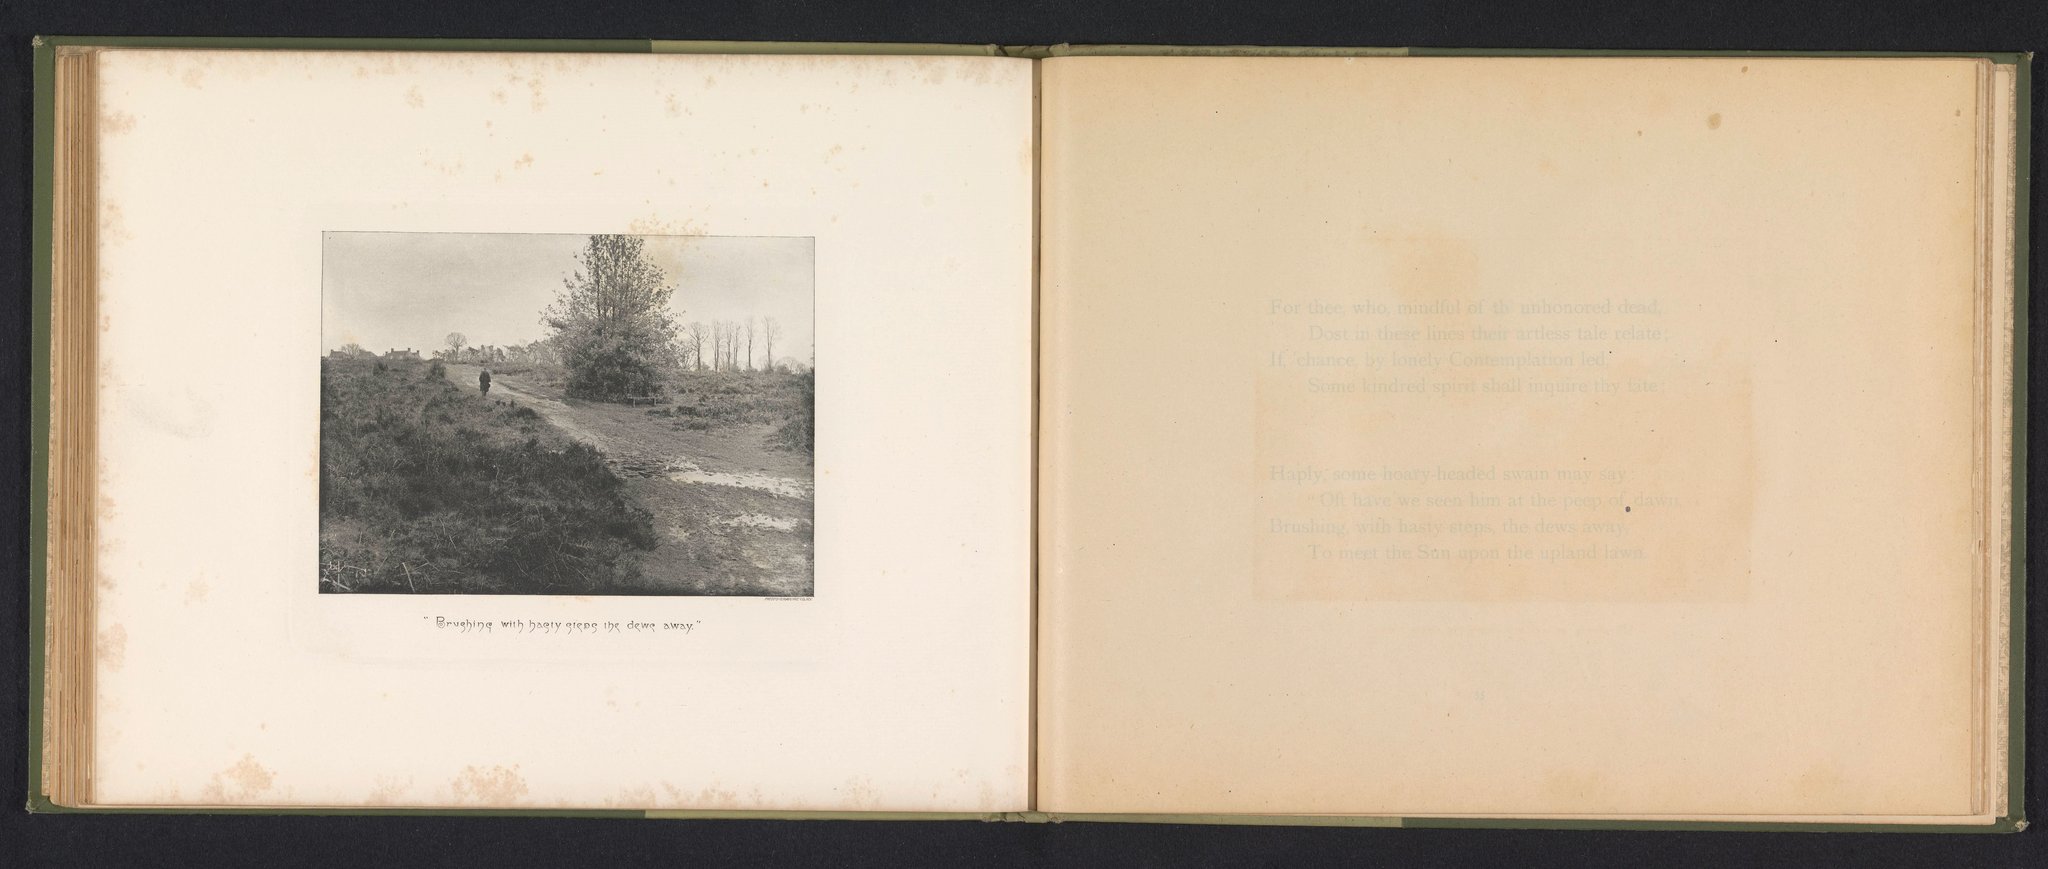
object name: photomechanical print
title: Brushing with hasty steps the dews away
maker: james leon williams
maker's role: fotograaf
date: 1881-1891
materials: paper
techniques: photoaquatint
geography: new york city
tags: road, path, england